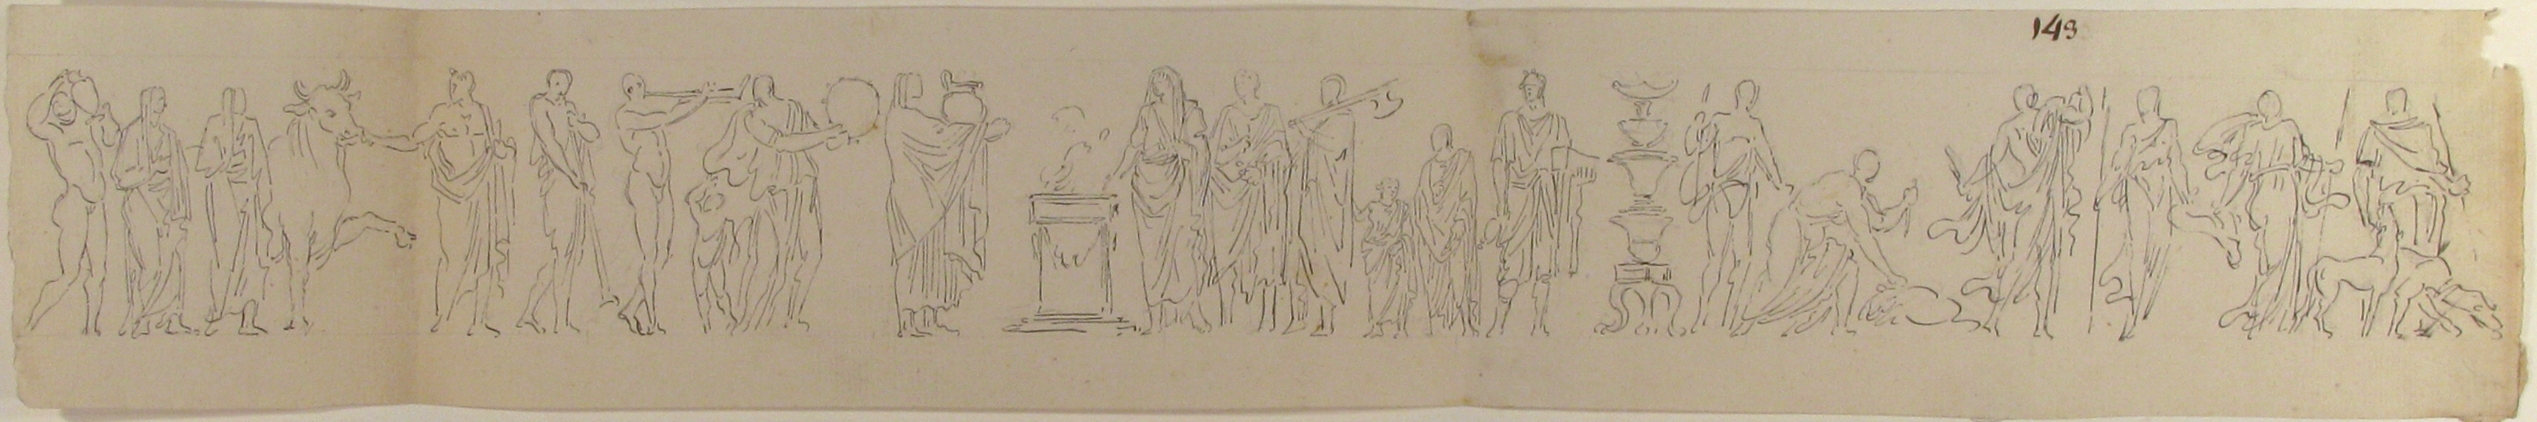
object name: drawing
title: Sacrificial Procession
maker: anonymous, french, 18th century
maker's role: artist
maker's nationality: french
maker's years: 1700-1800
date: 1701-1800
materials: graphite, ink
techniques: pen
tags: musical instruments,men,male nudes,women,cows